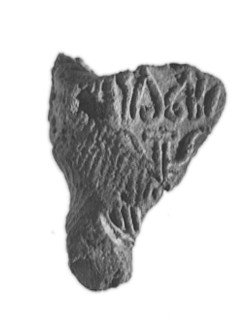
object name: sealing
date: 2030-1640 BCE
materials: clay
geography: egypt